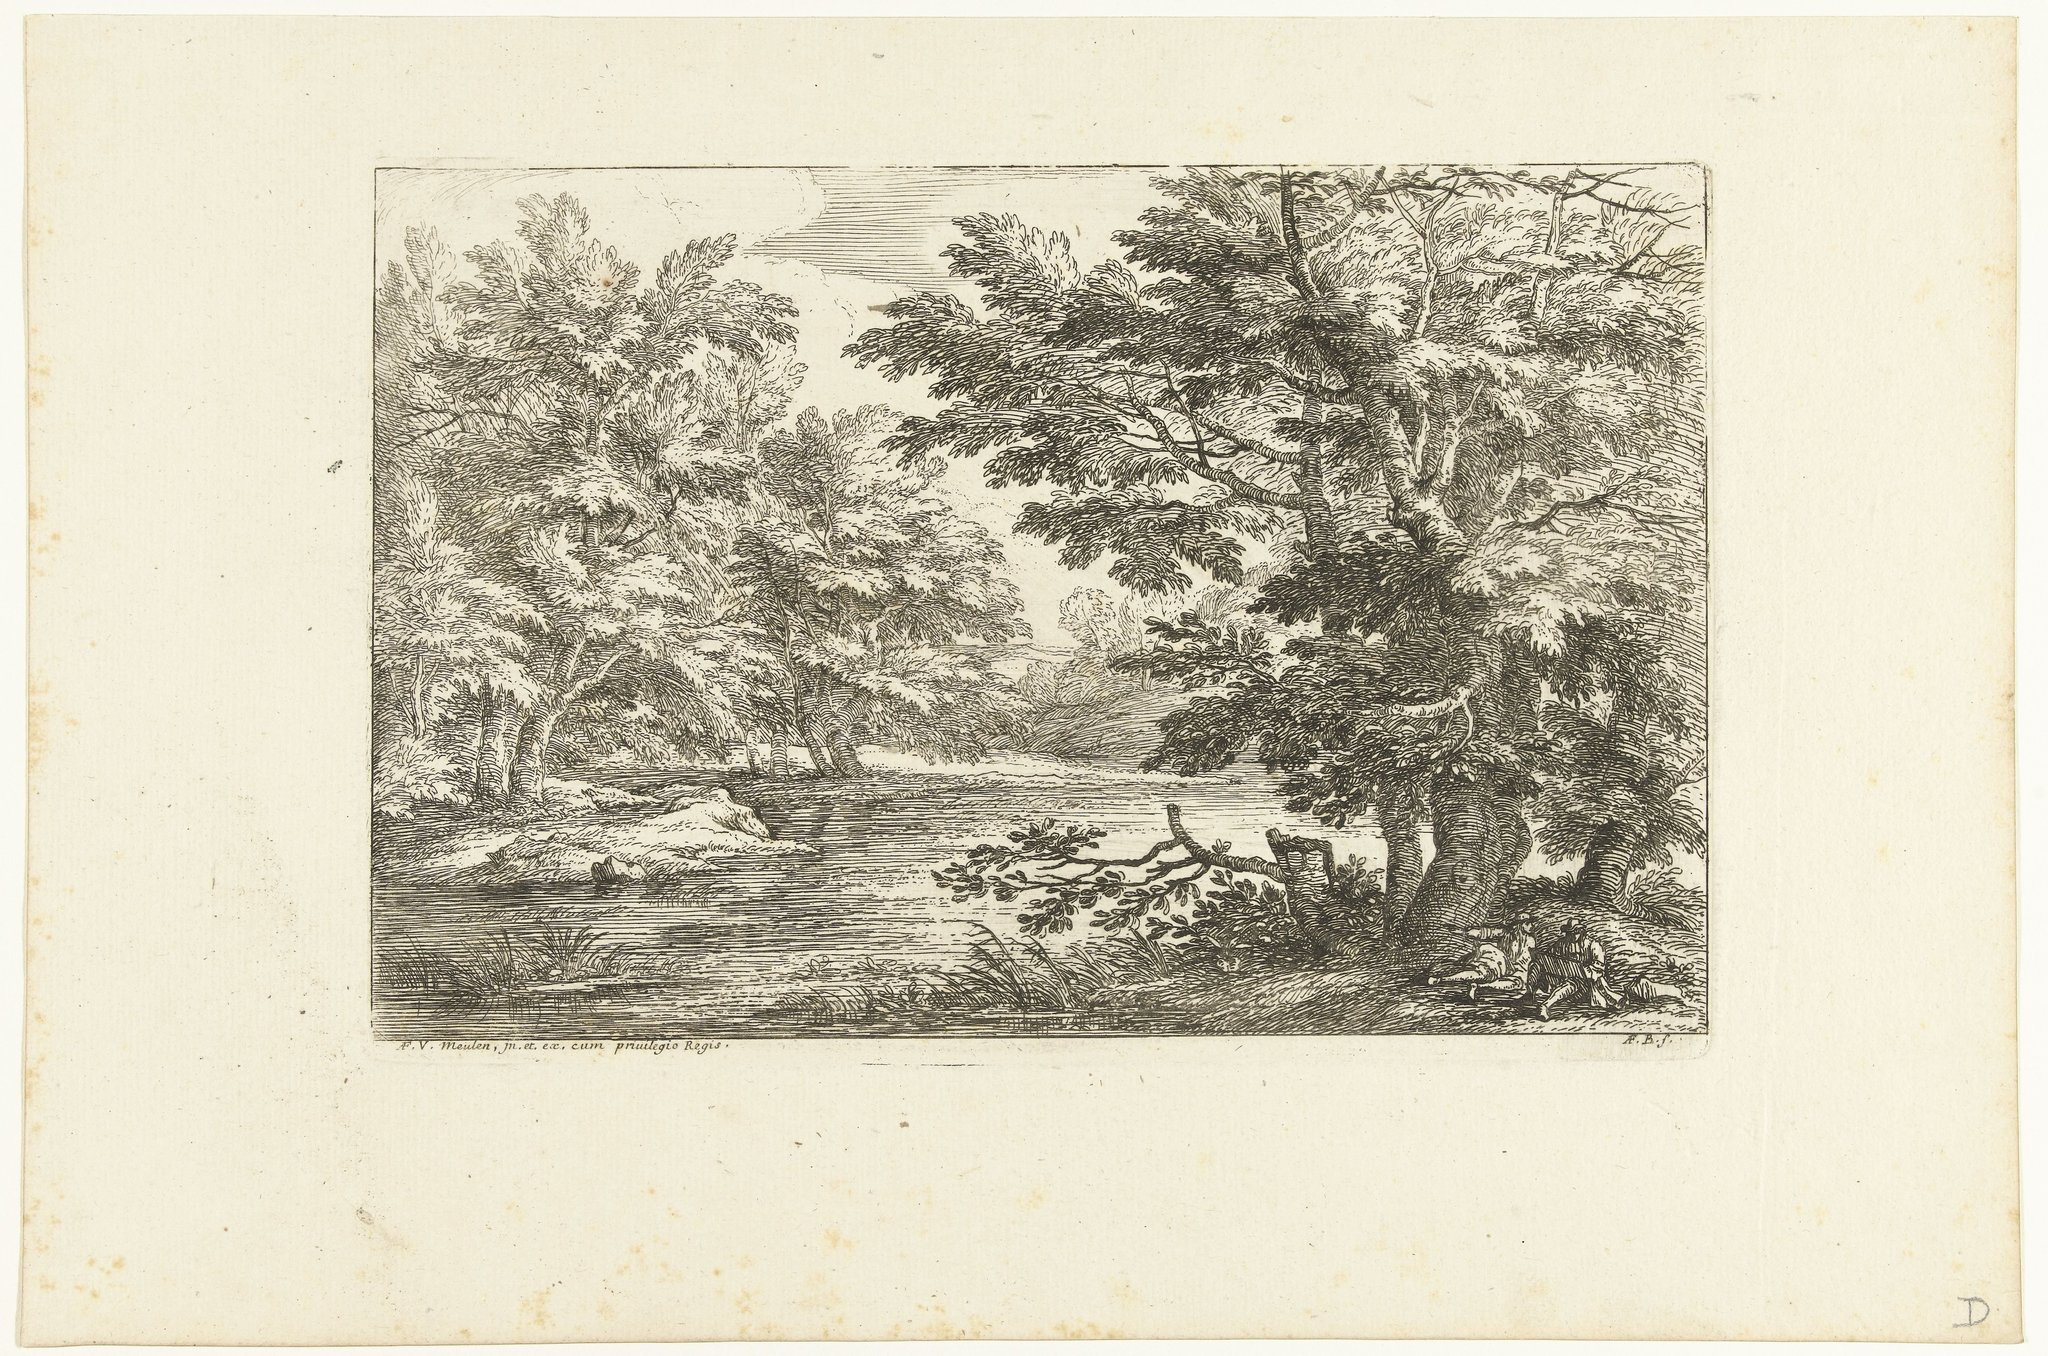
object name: print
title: Landschap met meertje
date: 1666-1681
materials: paper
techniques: etching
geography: paris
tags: lake, artist (in general) making preliminary designs, sketching - bb - out of doors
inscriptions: collector's mark: Lugt 2228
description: Aan de oever van het meer zit een kunstenaar te tekenen. Naast hem zit een andere man die met zijn hand naar iets wijst.